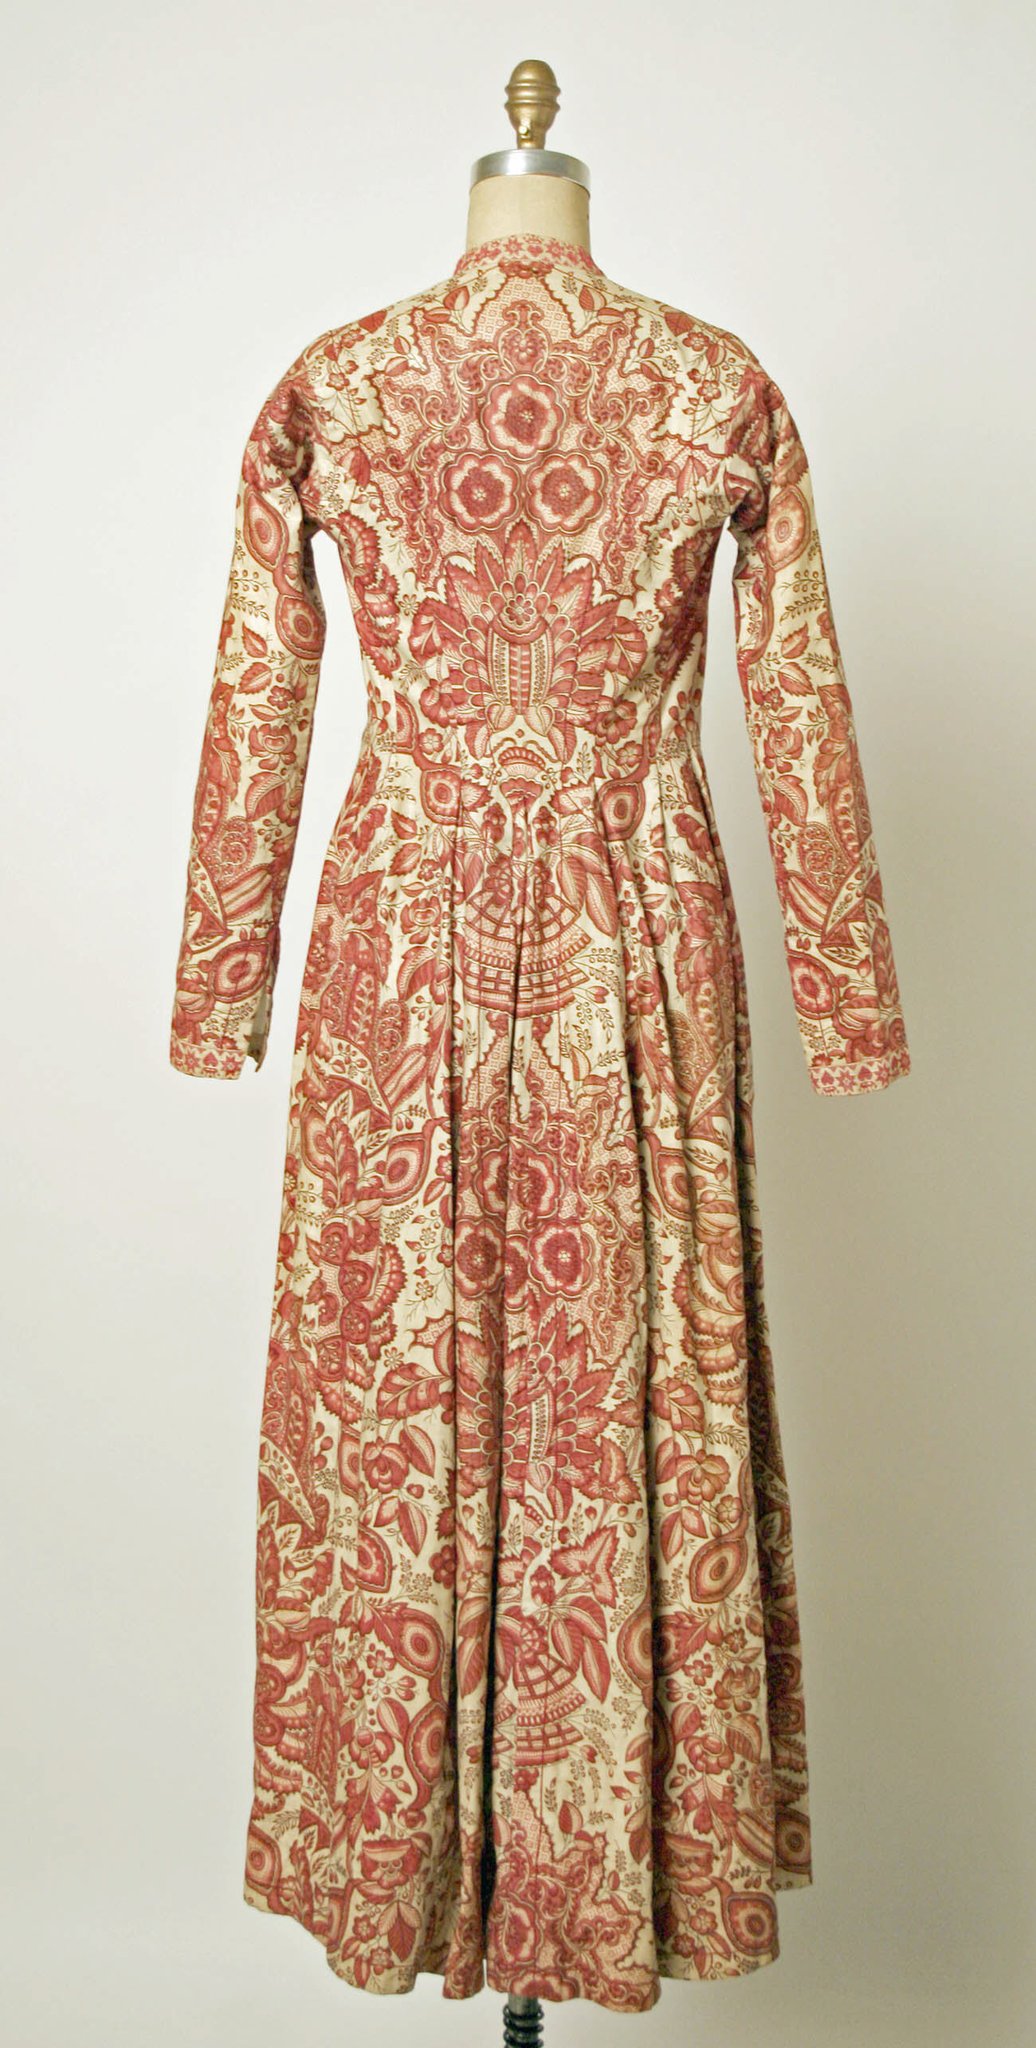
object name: dress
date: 1701-1900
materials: cotton